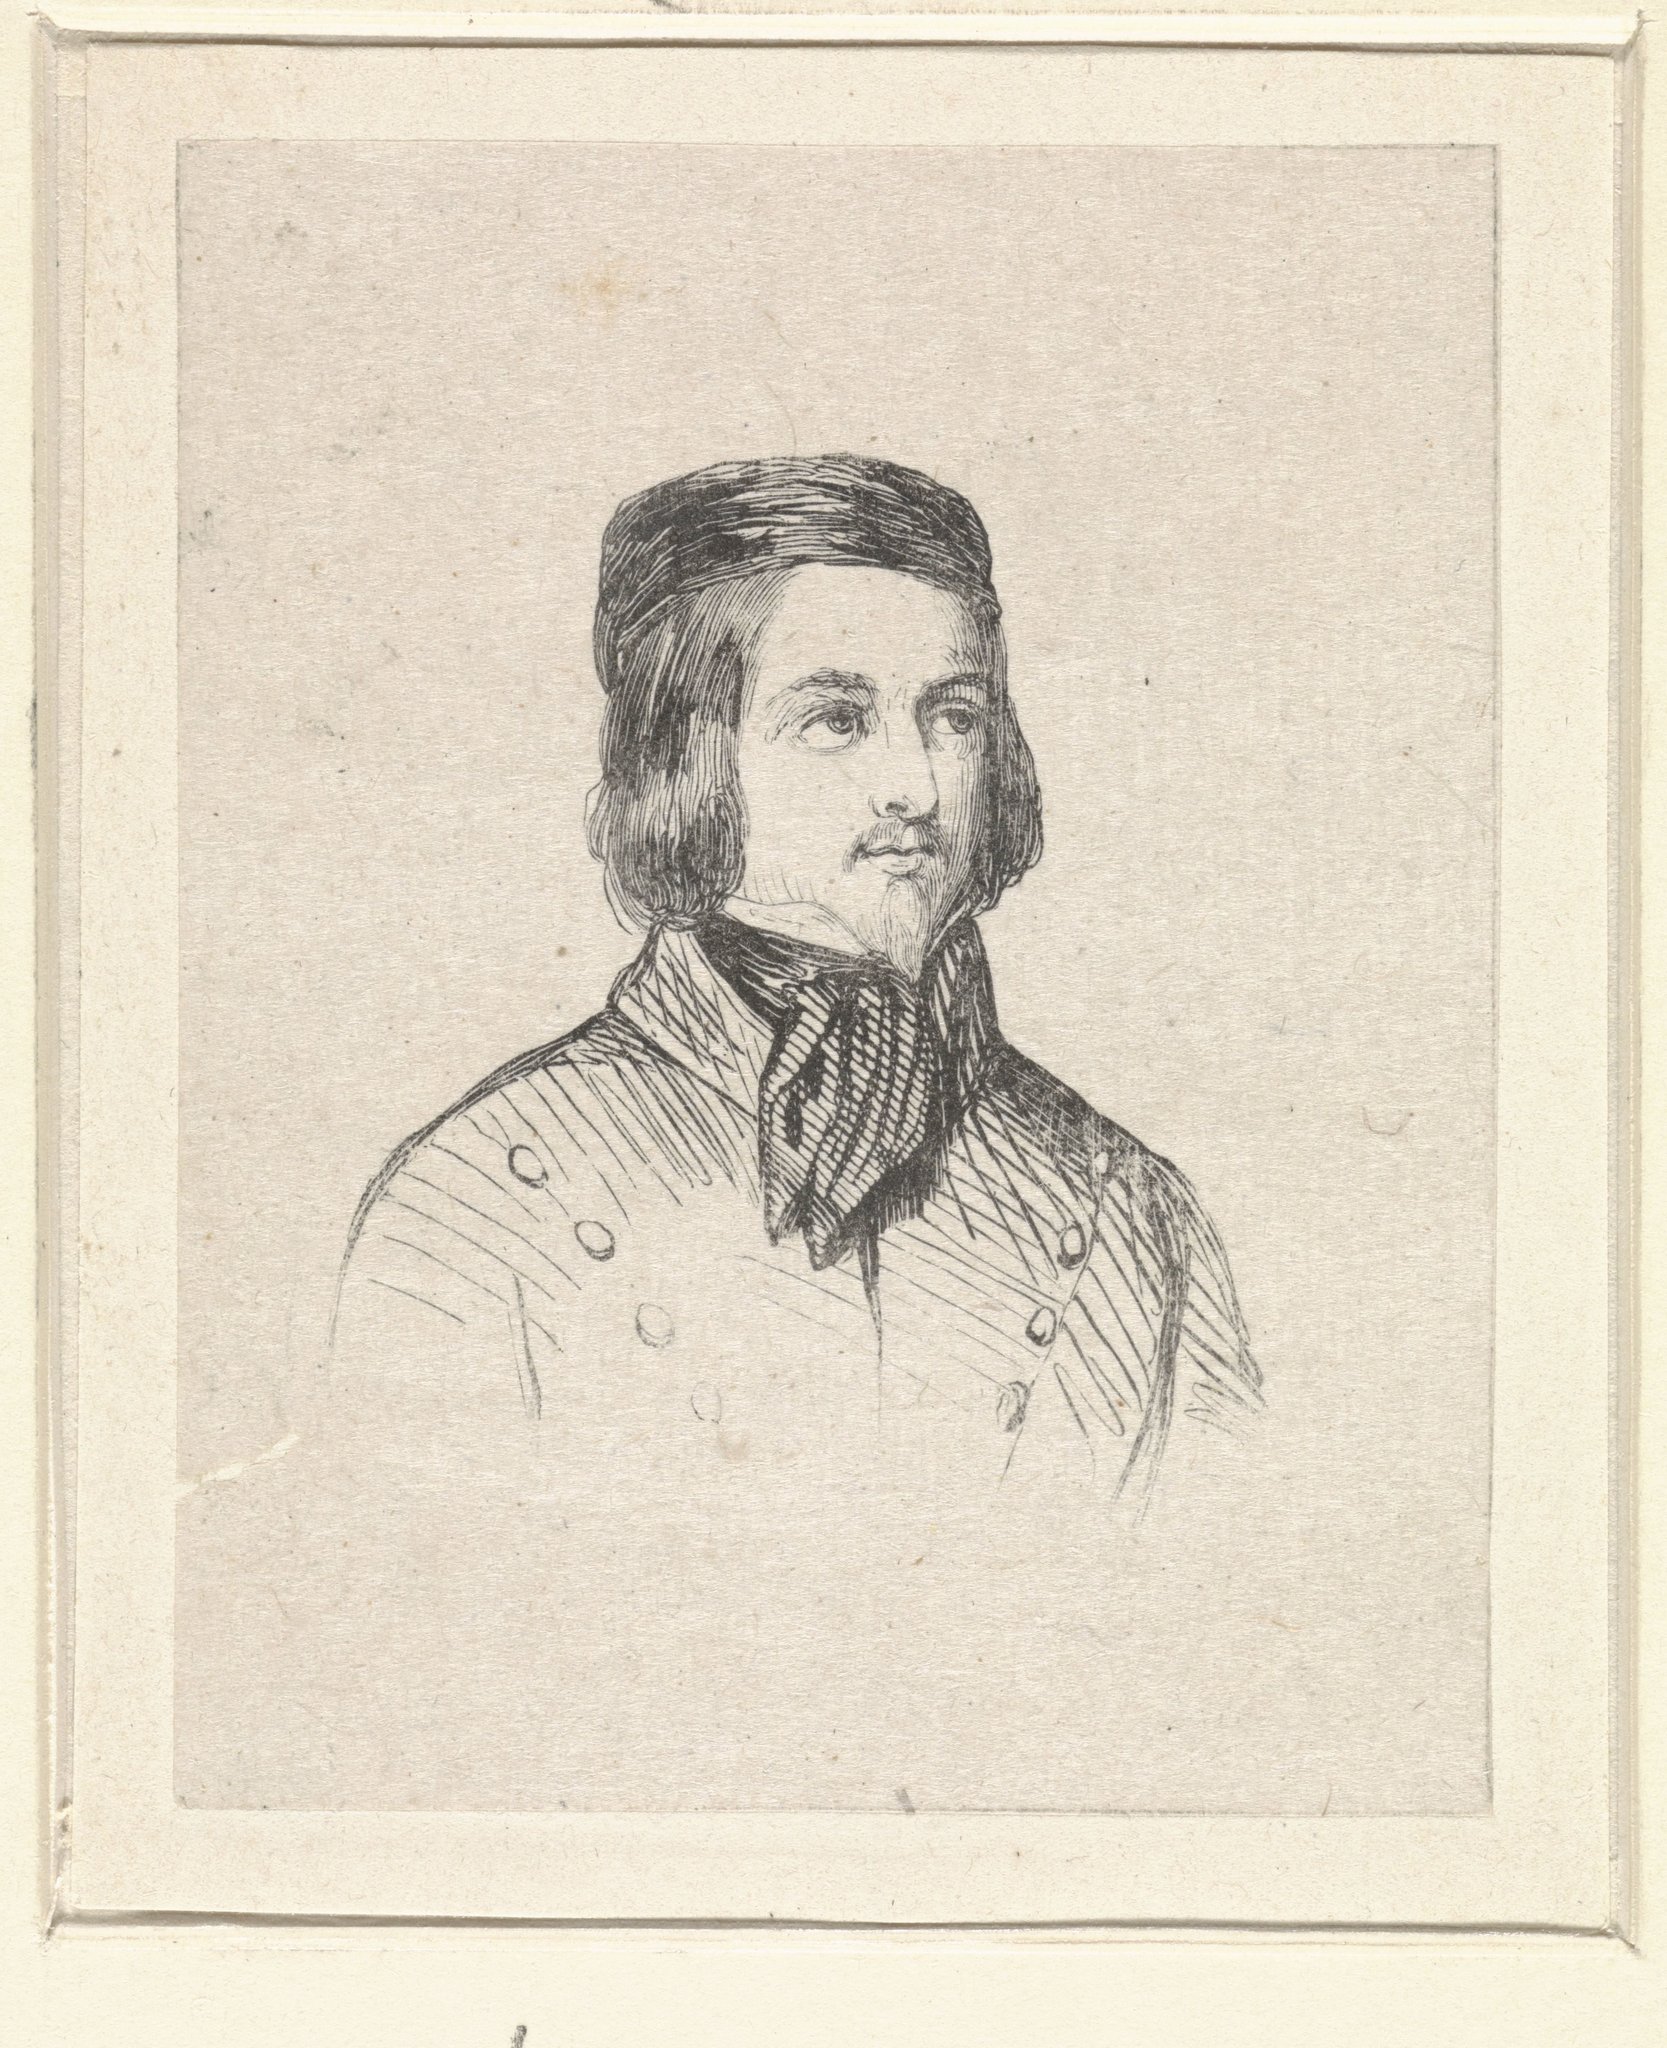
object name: print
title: Portret van Aloysius Geefs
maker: Anonymous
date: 1841-1842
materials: paper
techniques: engraving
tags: painter, aloysius geefs, historical persons, portrait, self-portrait of painter, portrait, self-portrait of artist, portrait, self-portrait of draughtsman